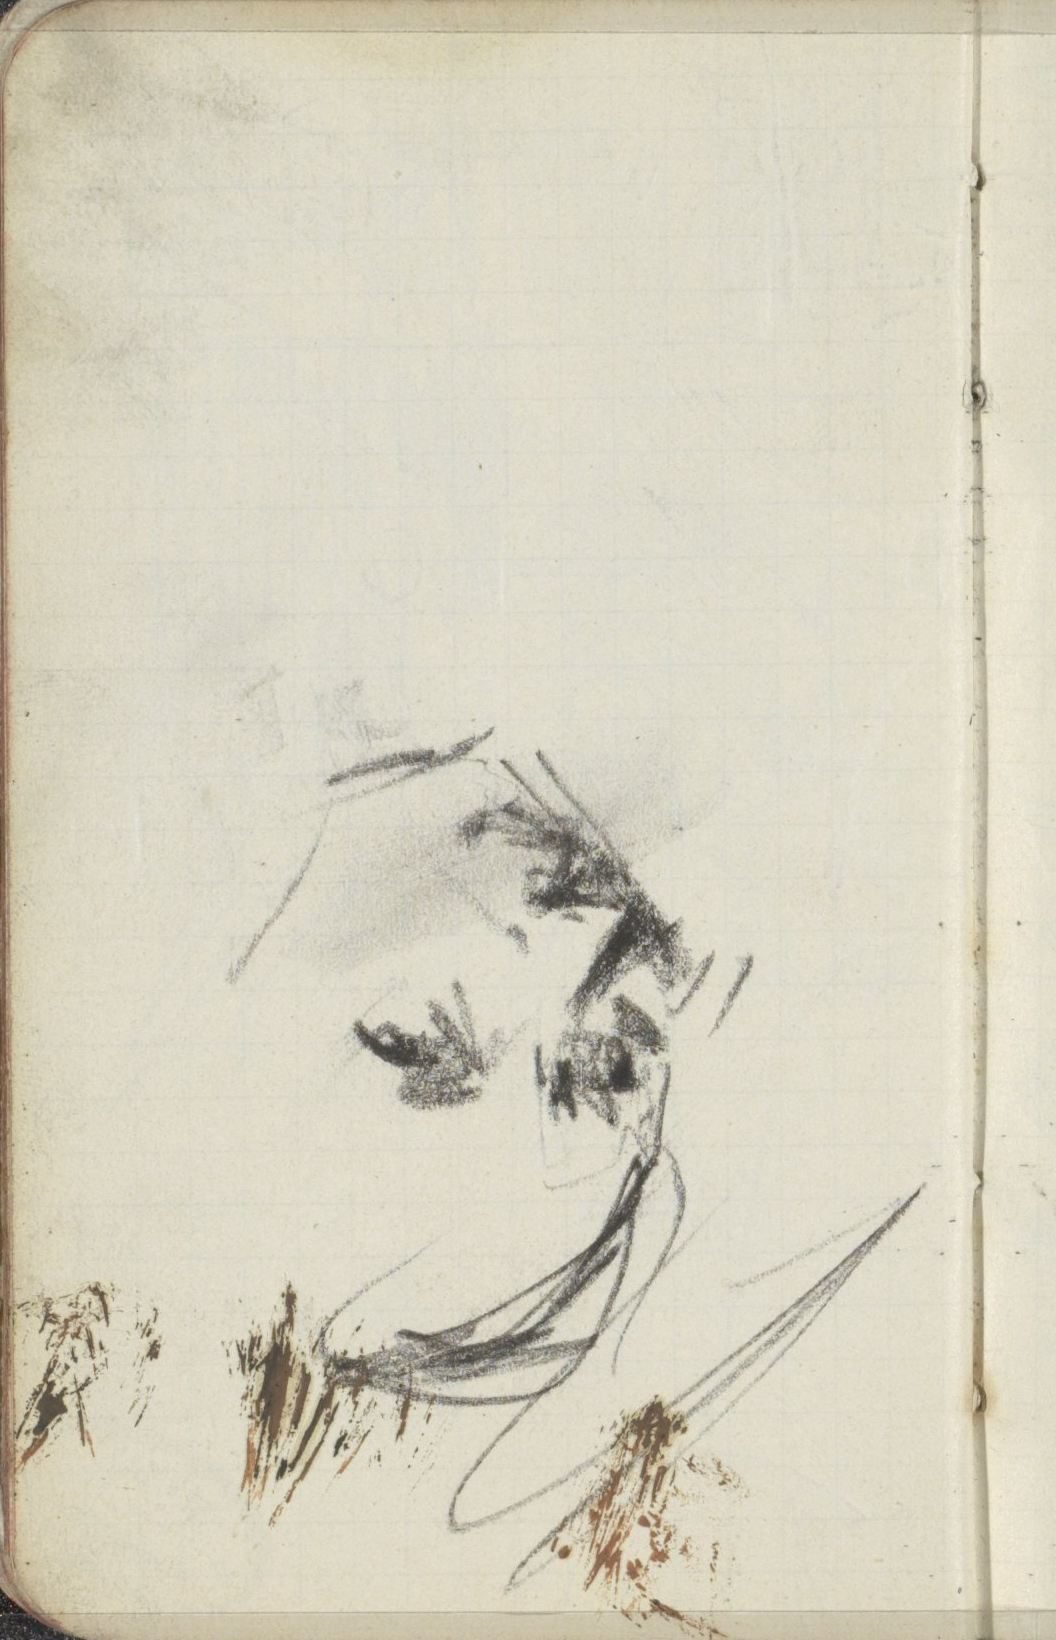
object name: sketchbook leaf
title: Gezicht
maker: george hendrik breitner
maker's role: draughtsman, painter, print maker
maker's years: 1857-1923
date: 1896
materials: chalk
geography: amsterdam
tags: face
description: Pagina 37 uit een schetsboek met 20 bladen.